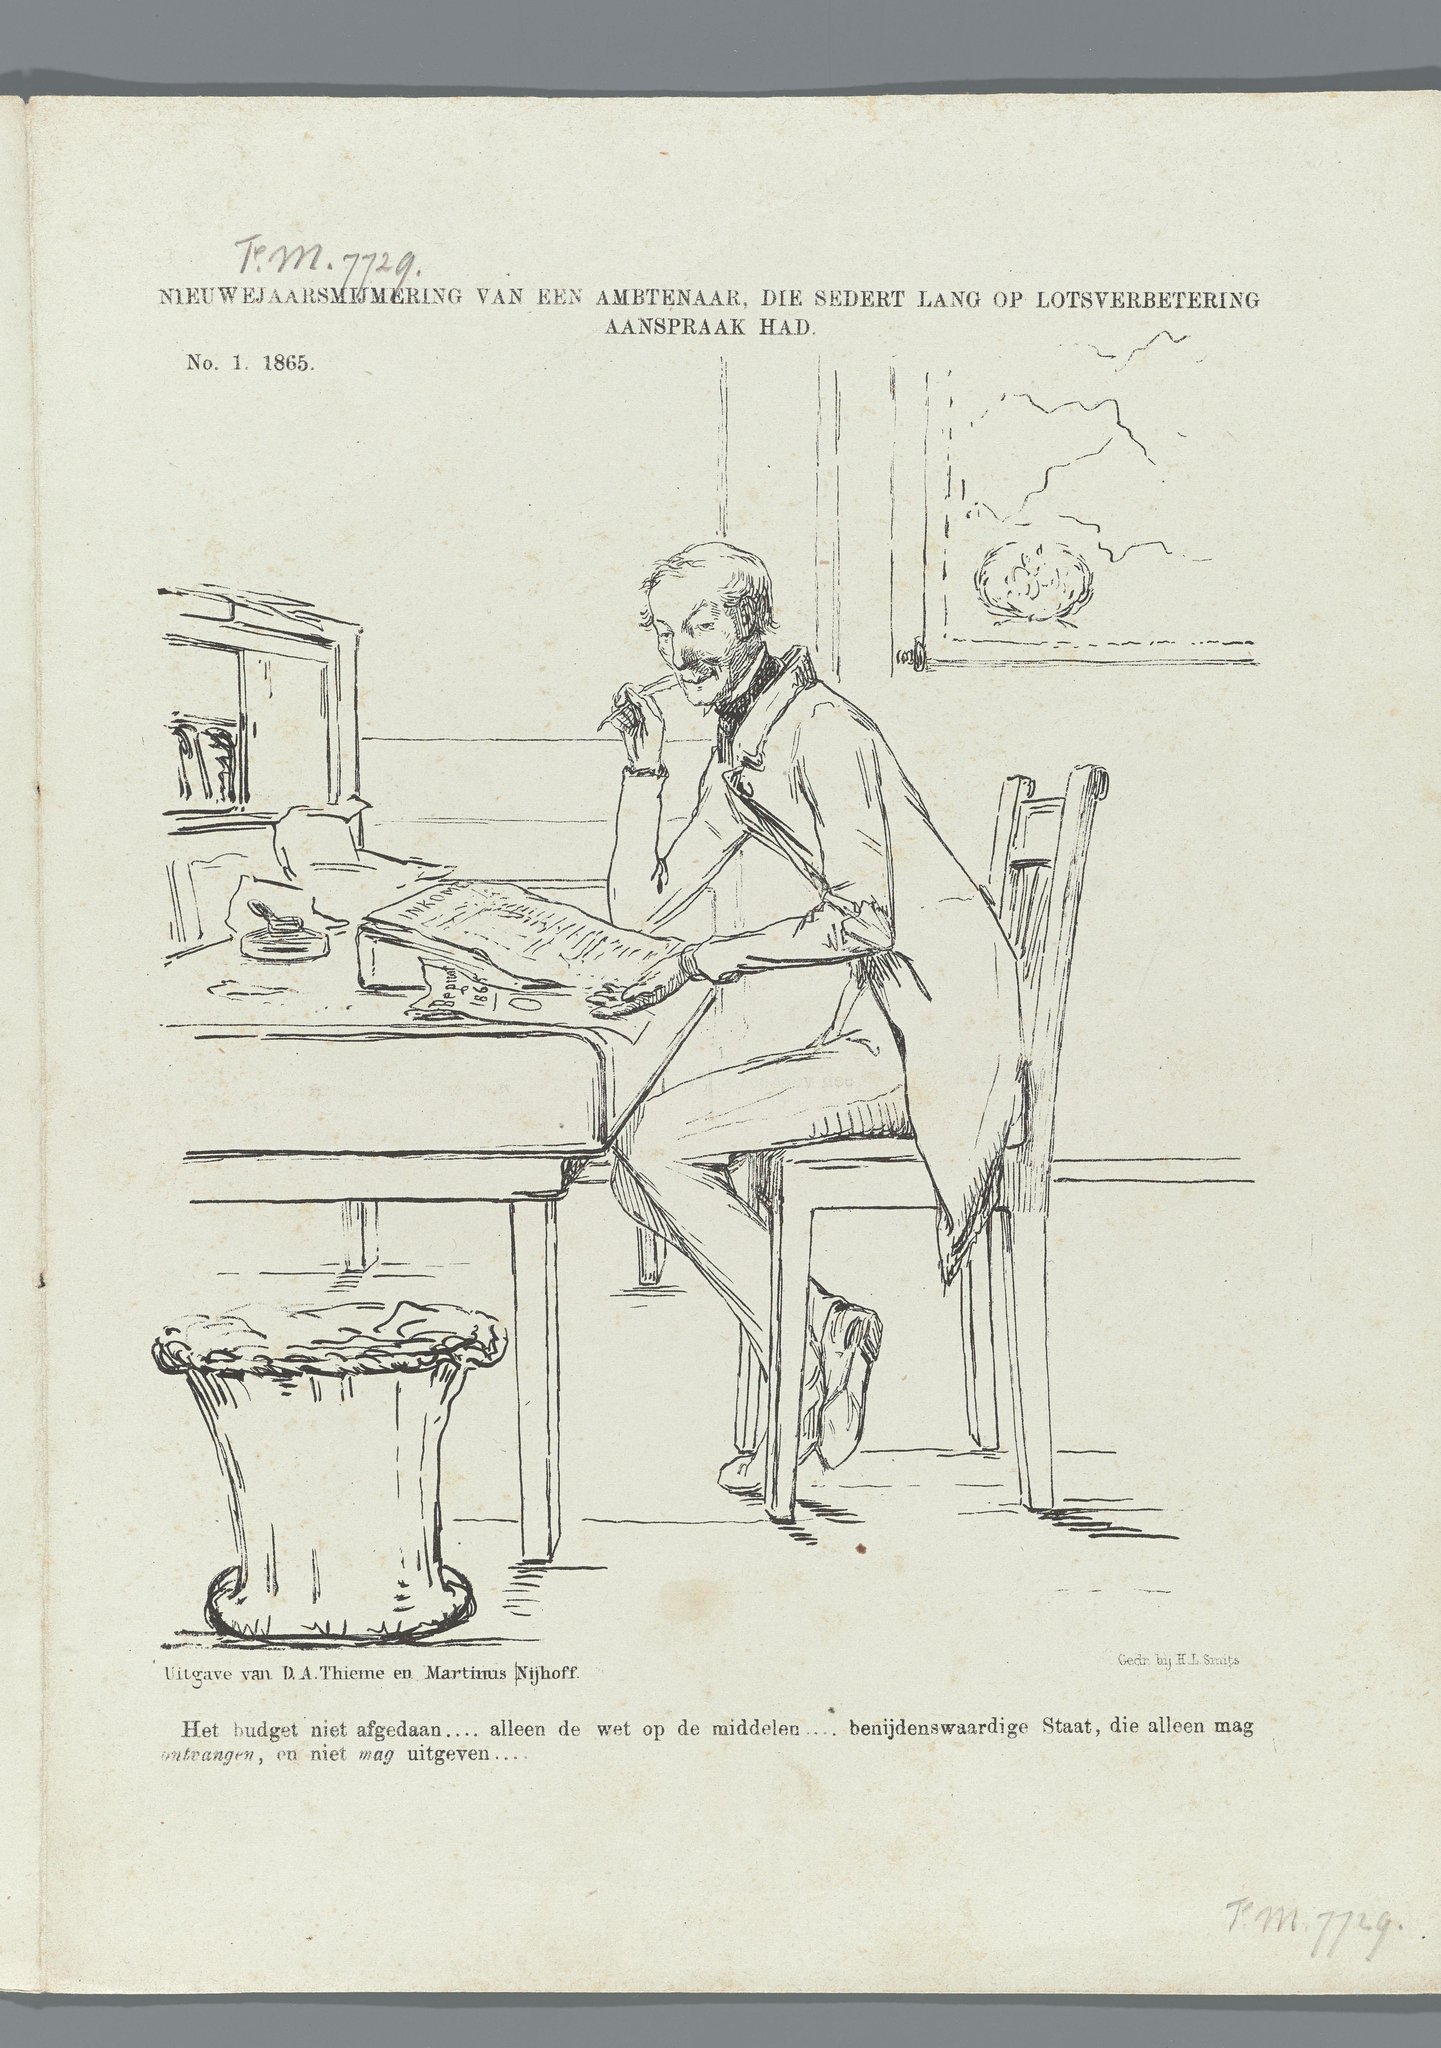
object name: cartoon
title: Nieuwjaarsmijmering van een ambtenaar, die sedert lang op lotsverbetering aanspraak had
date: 1865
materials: paper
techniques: lithograph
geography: netherlands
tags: official; civil servant; functionary (in general)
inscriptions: collector's mark: Lugt 2228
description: Spotprent op het niet afhandelen van de rijksbegroting van 1865 waarin een verbetering van positie van lage ambtenaren gepland stond. Een ambtenaar zittend achter zijn bureau. Plaat verschenen bij het weekblad De Nederlandsche Spectator, nr. 1, 7 januari 1865.